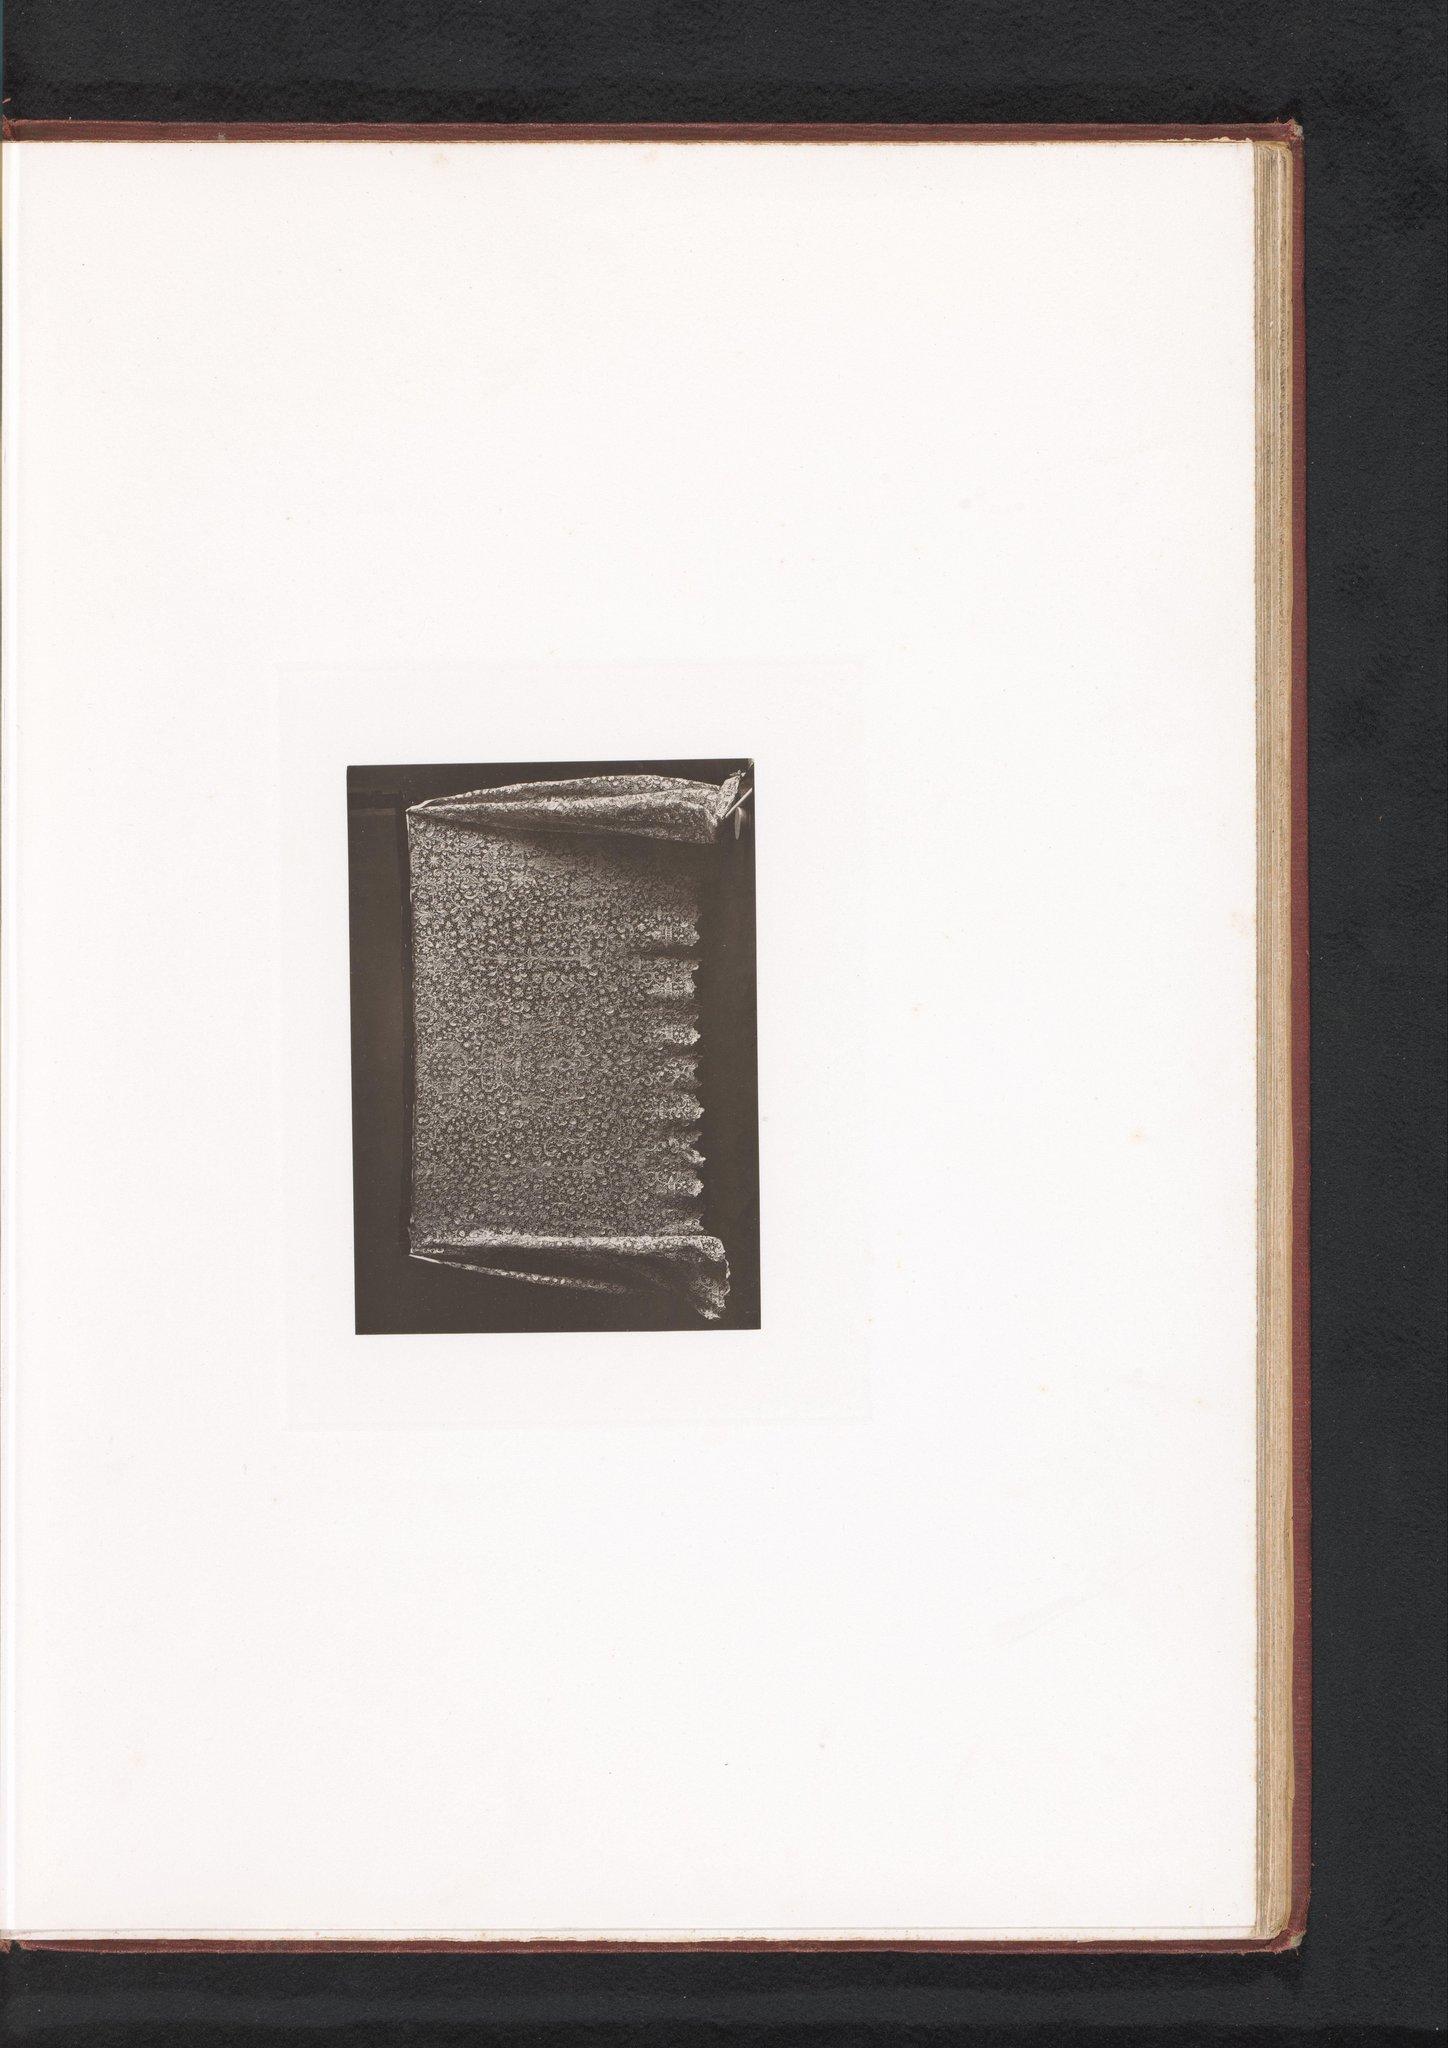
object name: photomechanical print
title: Kleed met 17de-eeuws Frans borduurwerk, opgesteld tijdens de Exposition Rétrospective van 1873 in Tours, Frankrijk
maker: gabriel blaise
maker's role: printer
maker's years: 1827-1897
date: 1873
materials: paper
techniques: woodburytype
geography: tours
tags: embroidery (ornamentation), temporary exhibition, 'salon'